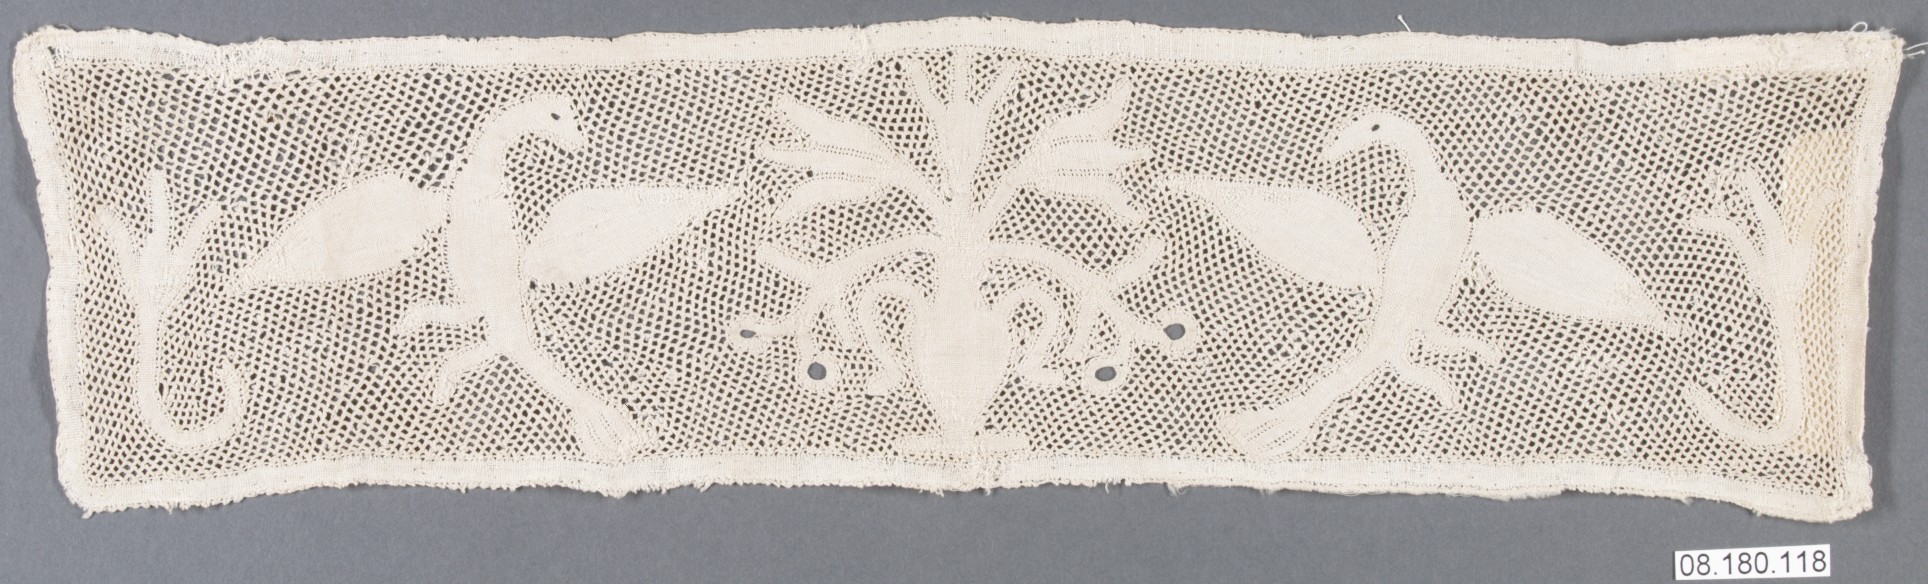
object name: fragment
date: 1701-1800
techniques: lace